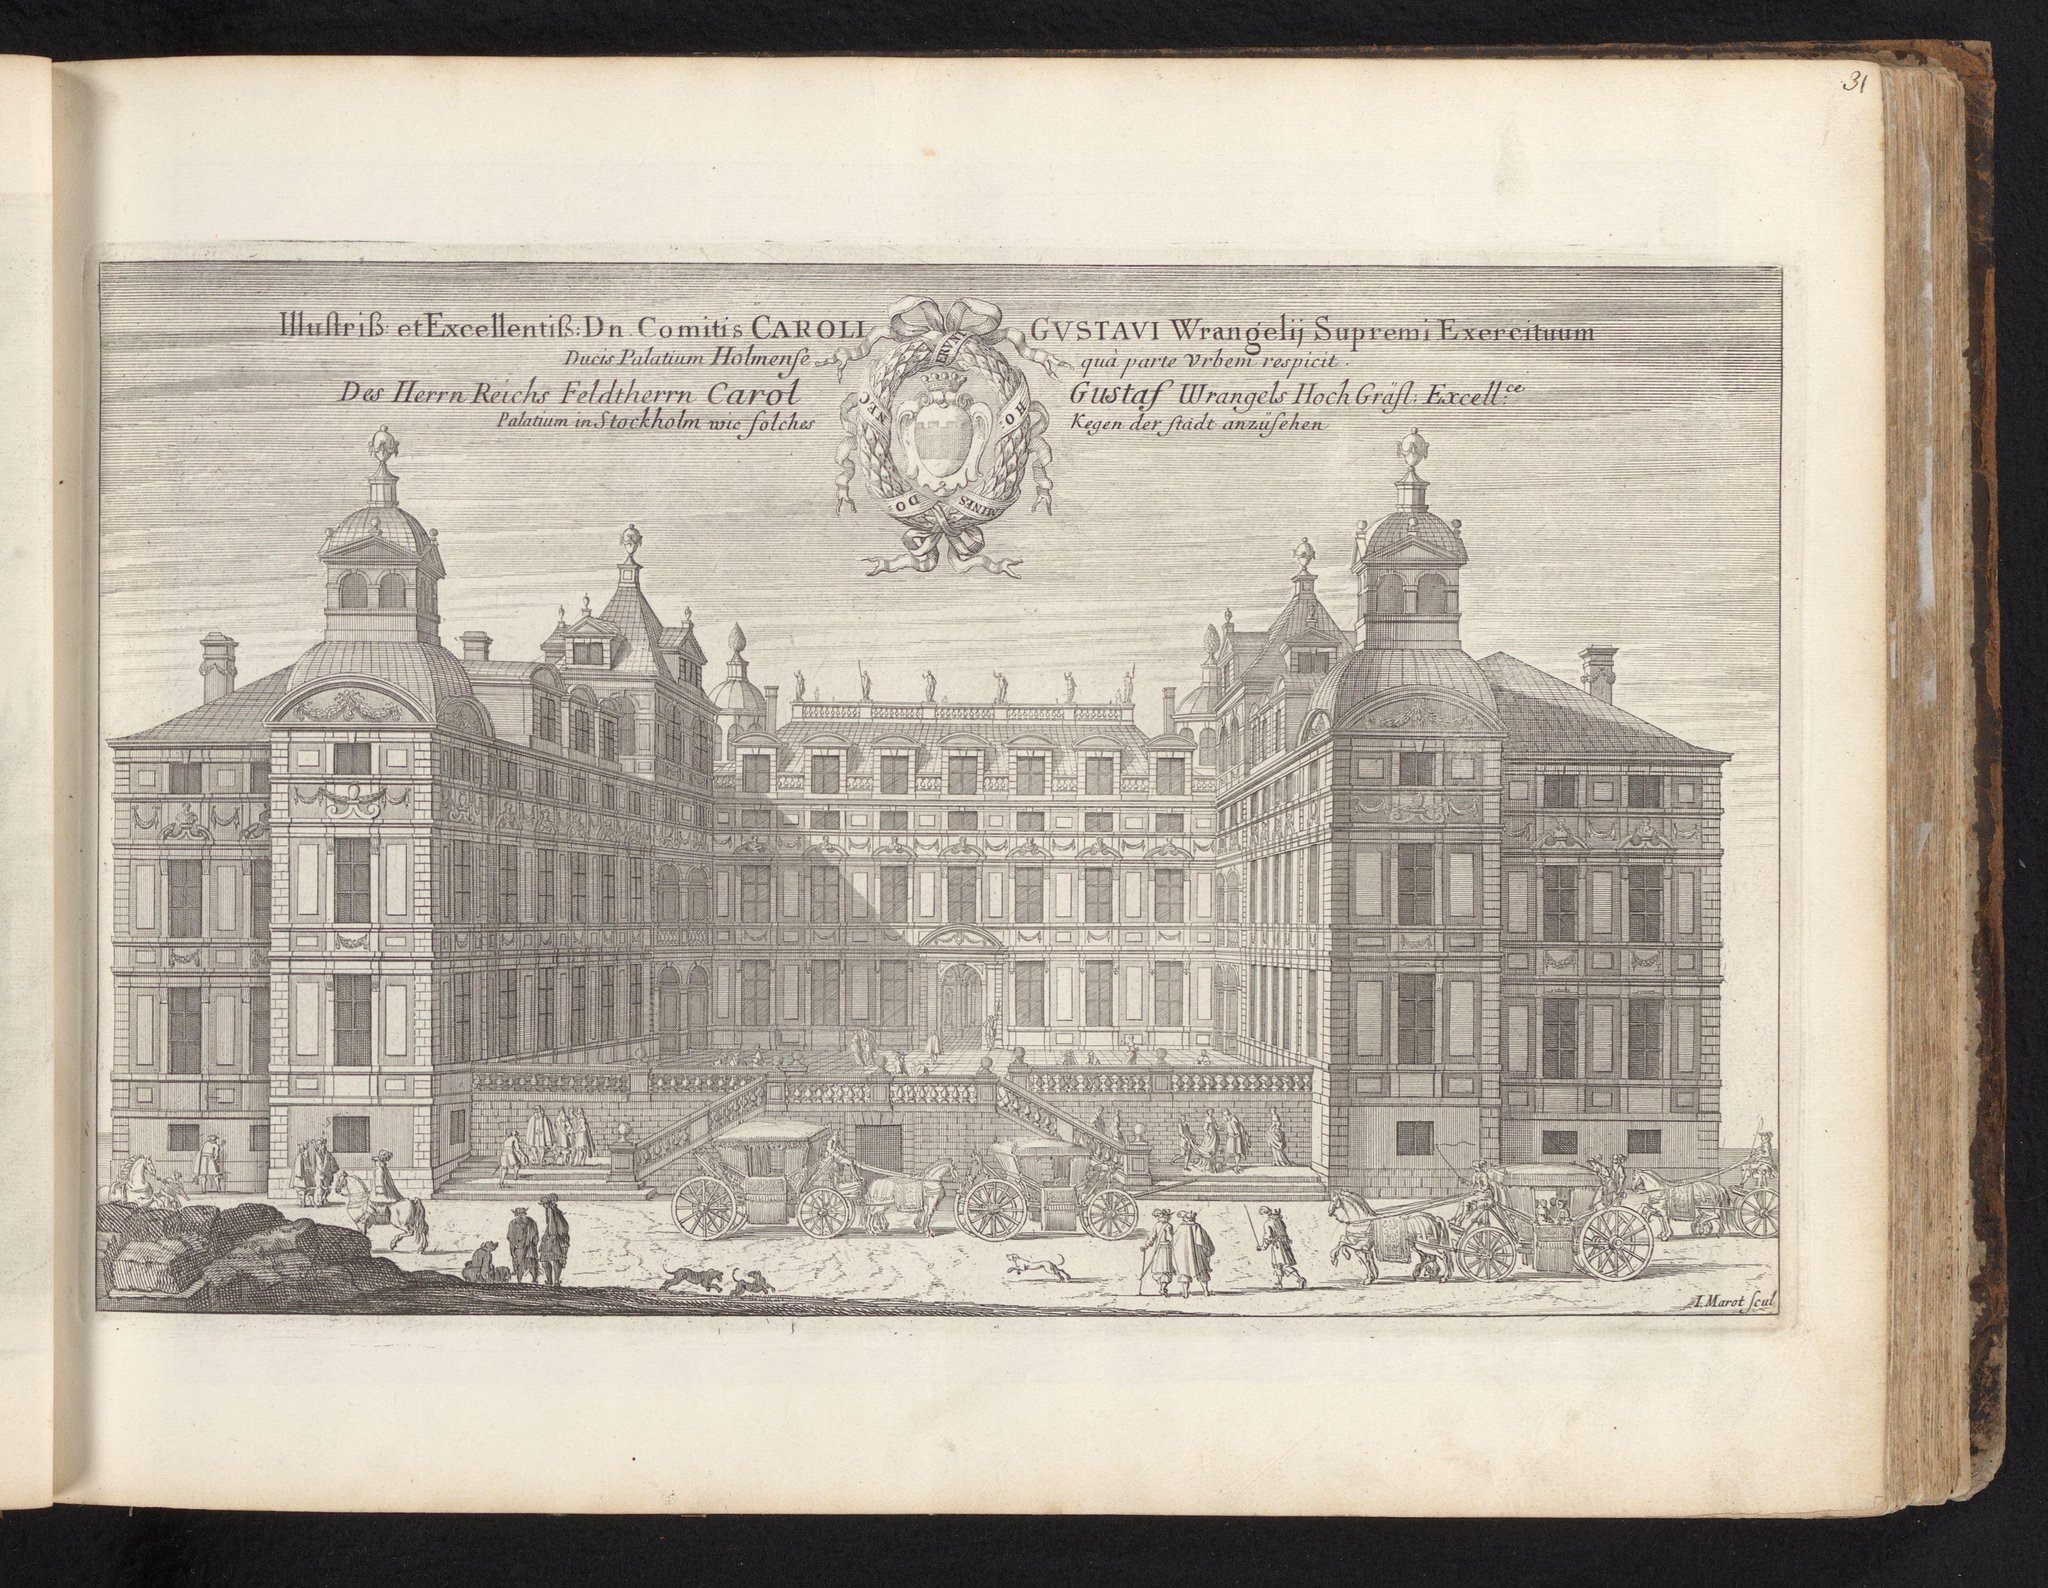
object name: album leaf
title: Paleis van Carl Gustaf Wrangel aan stadszijde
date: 1667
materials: paper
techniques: etching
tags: palace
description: Kungliga Biblioteket, 'Suecia': http://www.kb.se/samlingarna/Kartor-bilder/Suecia-antiqua/ (geraadpleegd november 2016).